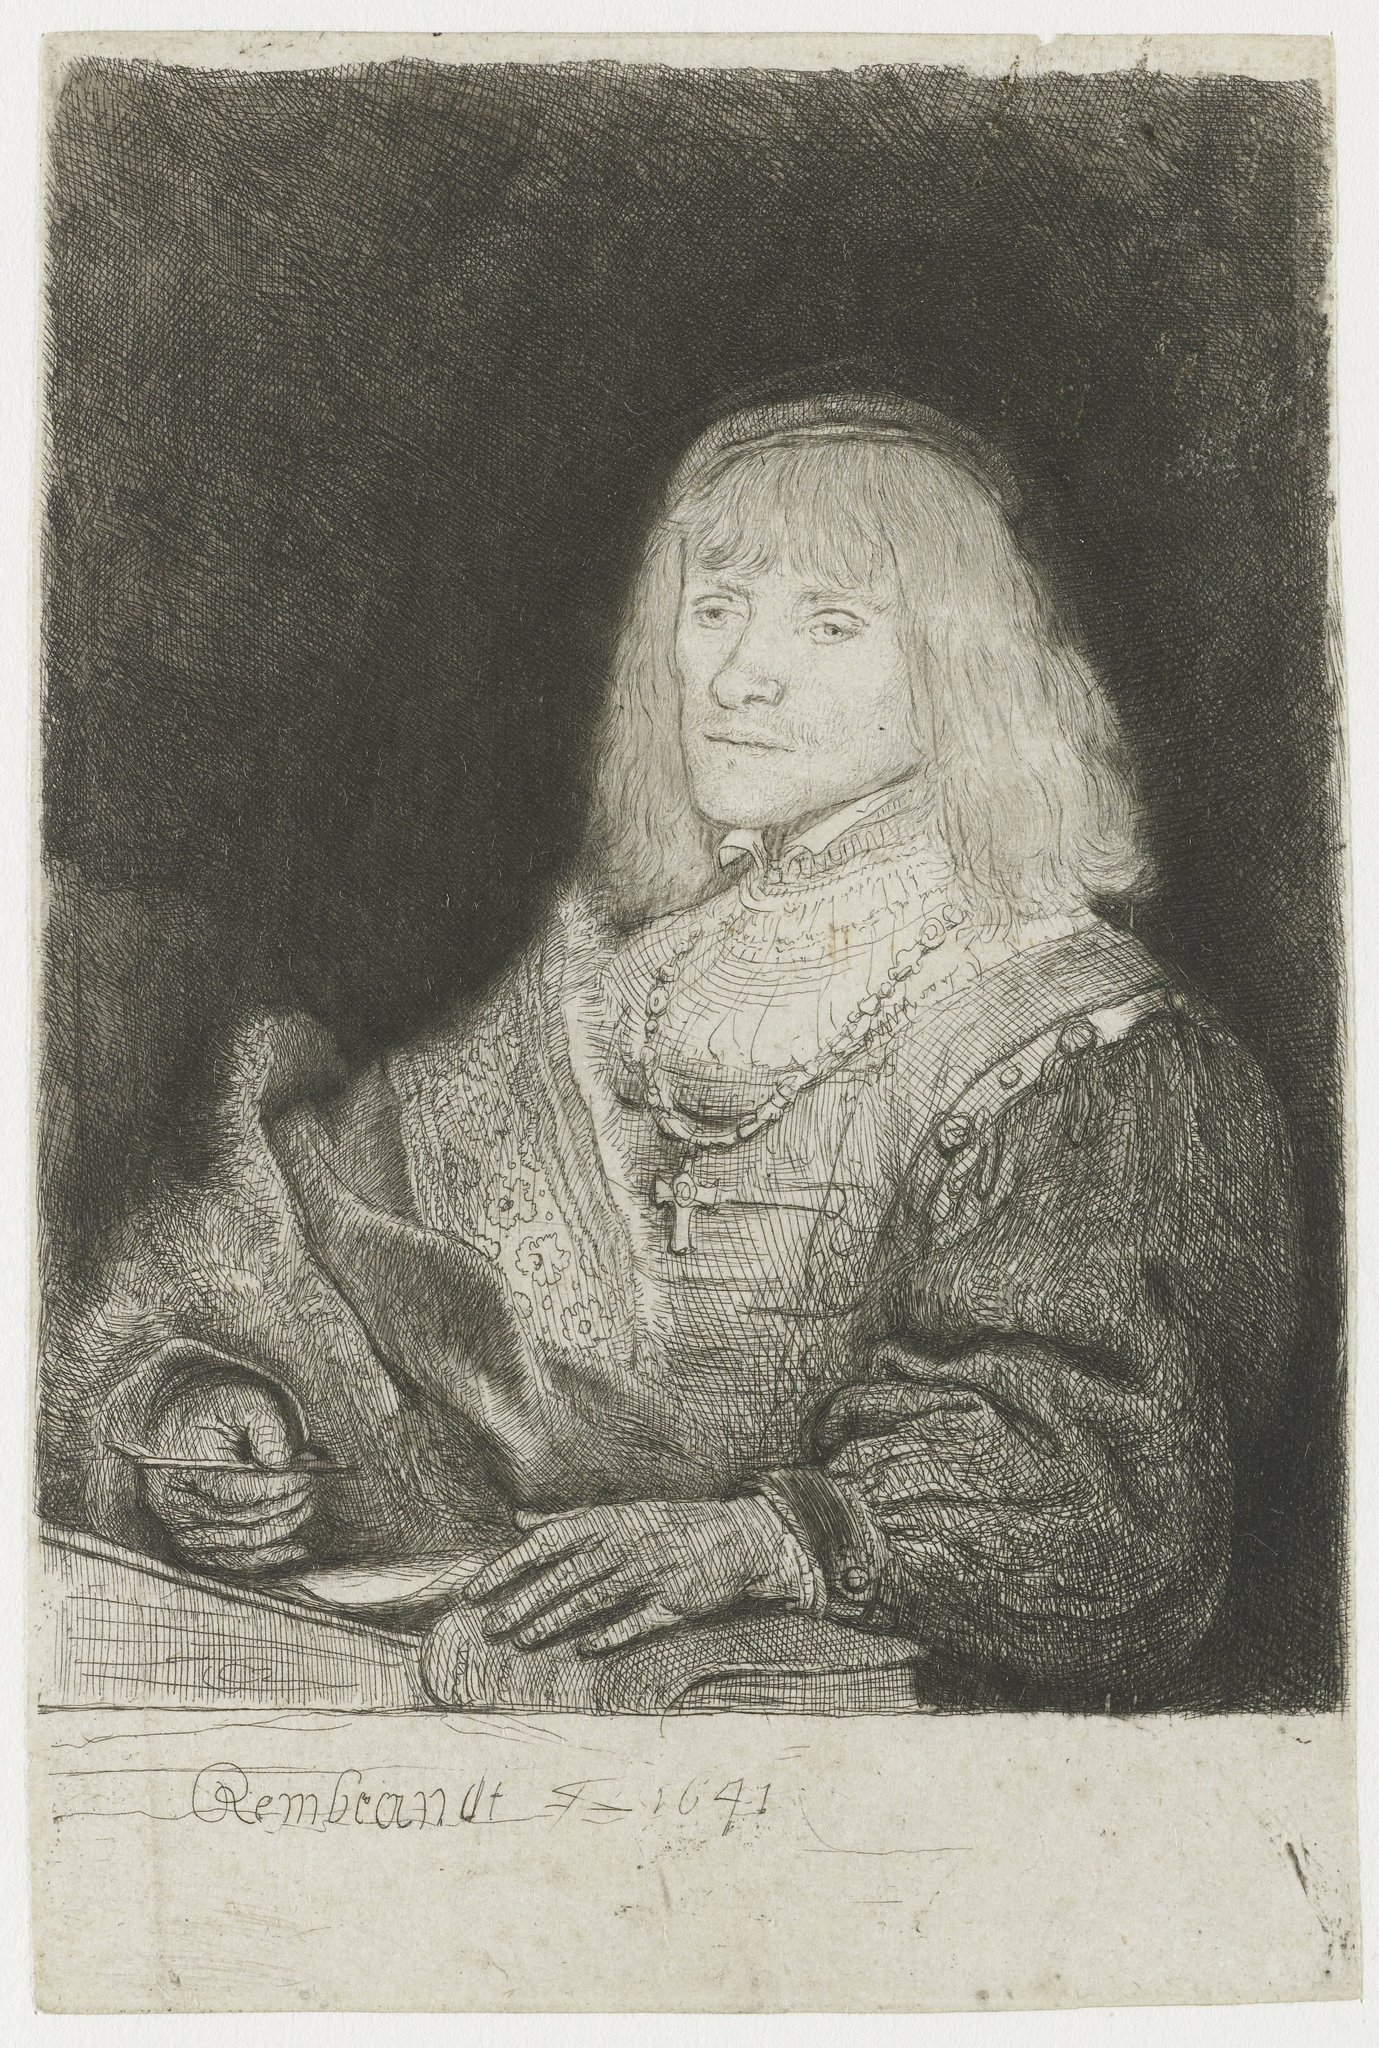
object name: print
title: Man at a desk wearing a cross and chain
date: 1641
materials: paper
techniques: drypoint, etching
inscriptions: inscription: ‘l'homme avec chaine et croix (...) de la planche’, signature and date: ‘Rembrandt f 1641’, collector's mark: Lugt 2228, inscription: ‘Jan Weissenbruch’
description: Prent van Rembrandt opgewerkt door een onbekende graveur.